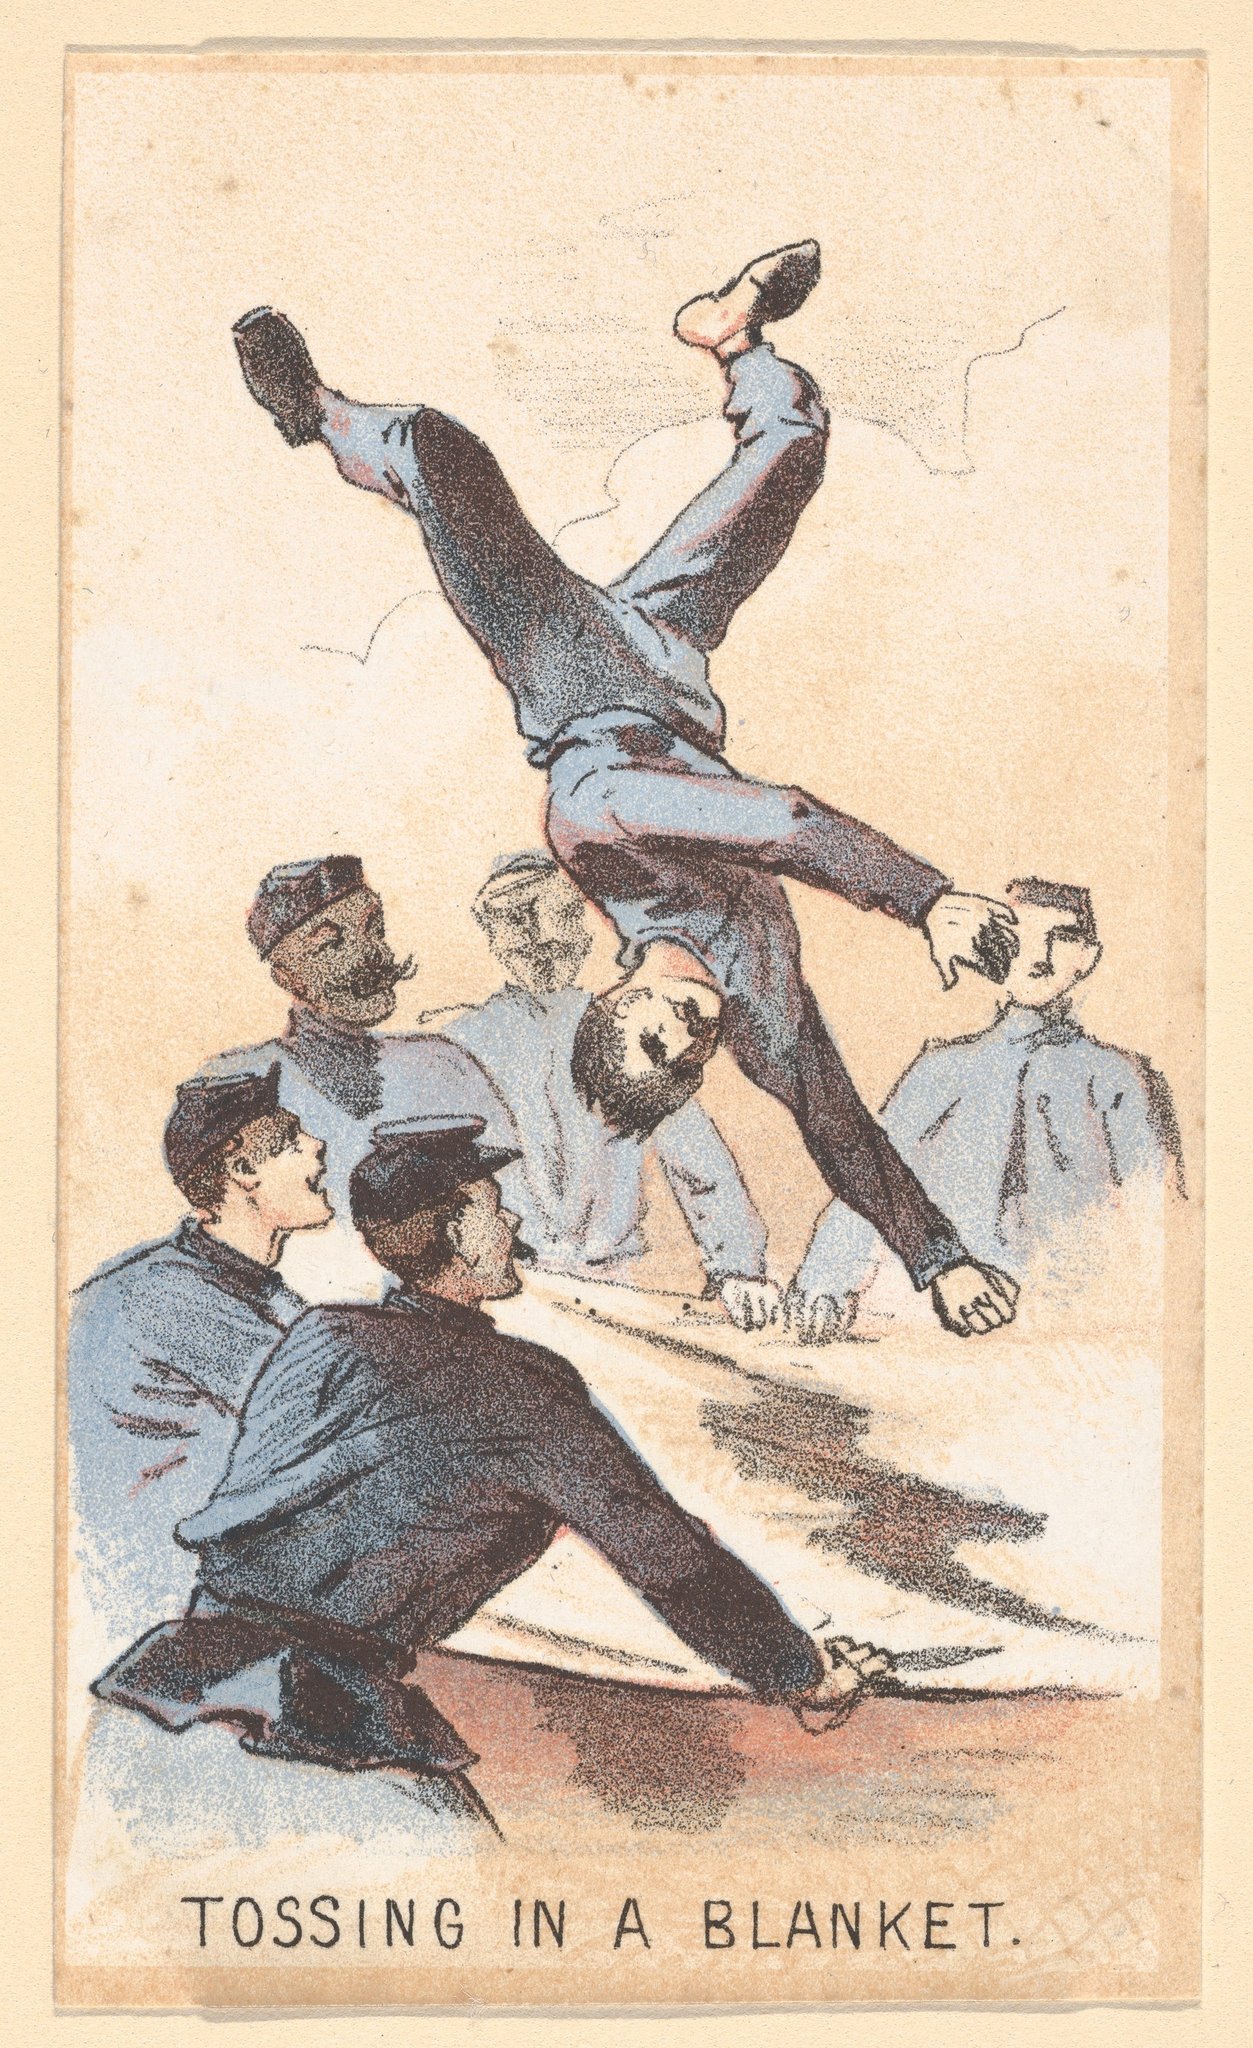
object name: print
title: Life in Camp, Part 1: Tossing in a Blanket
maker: winslow homer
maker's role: artist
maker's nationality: american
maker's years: 1836-1910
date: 1864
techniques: lithograph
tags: soldiers,american civil war,men,playing